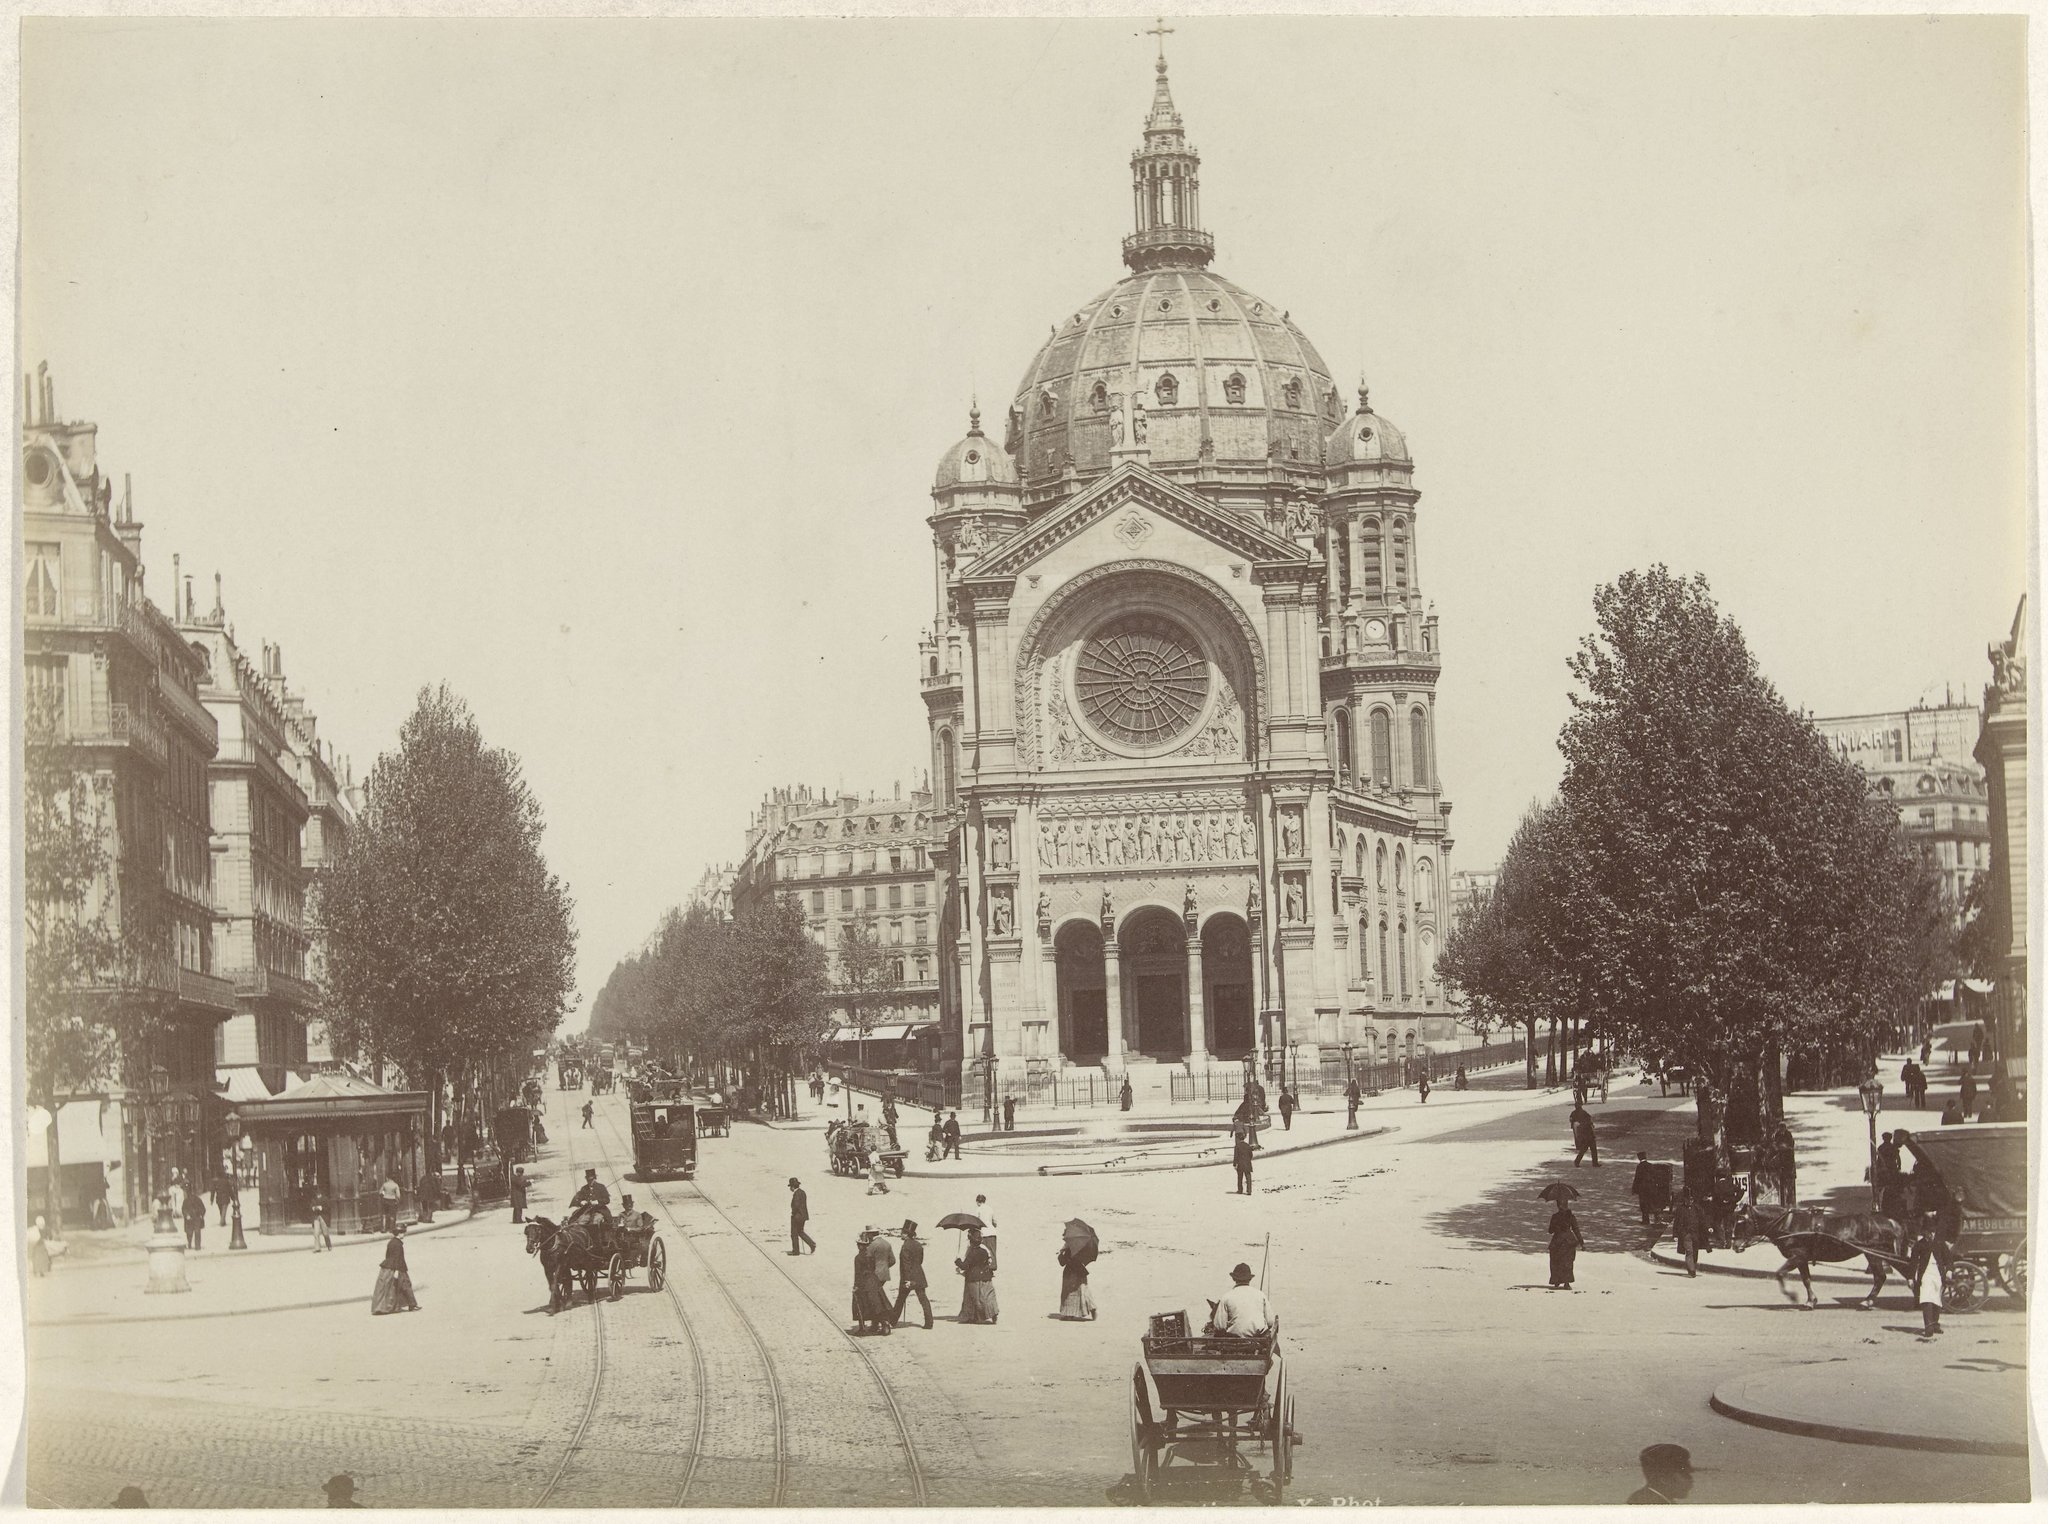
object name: photograph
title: Boulevard Malesherbes en de Saint-Augustin, Parijs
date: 1887-1900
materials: paper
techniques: albumen print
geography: paris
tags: church (exterior), avenue, boulevard, promenade, esplanade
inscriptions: inscription: ‘Paris’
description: Tussen 1887 en ca. 1900 werkten Neurdein frères onder andere onder de naam 'X phot.'.